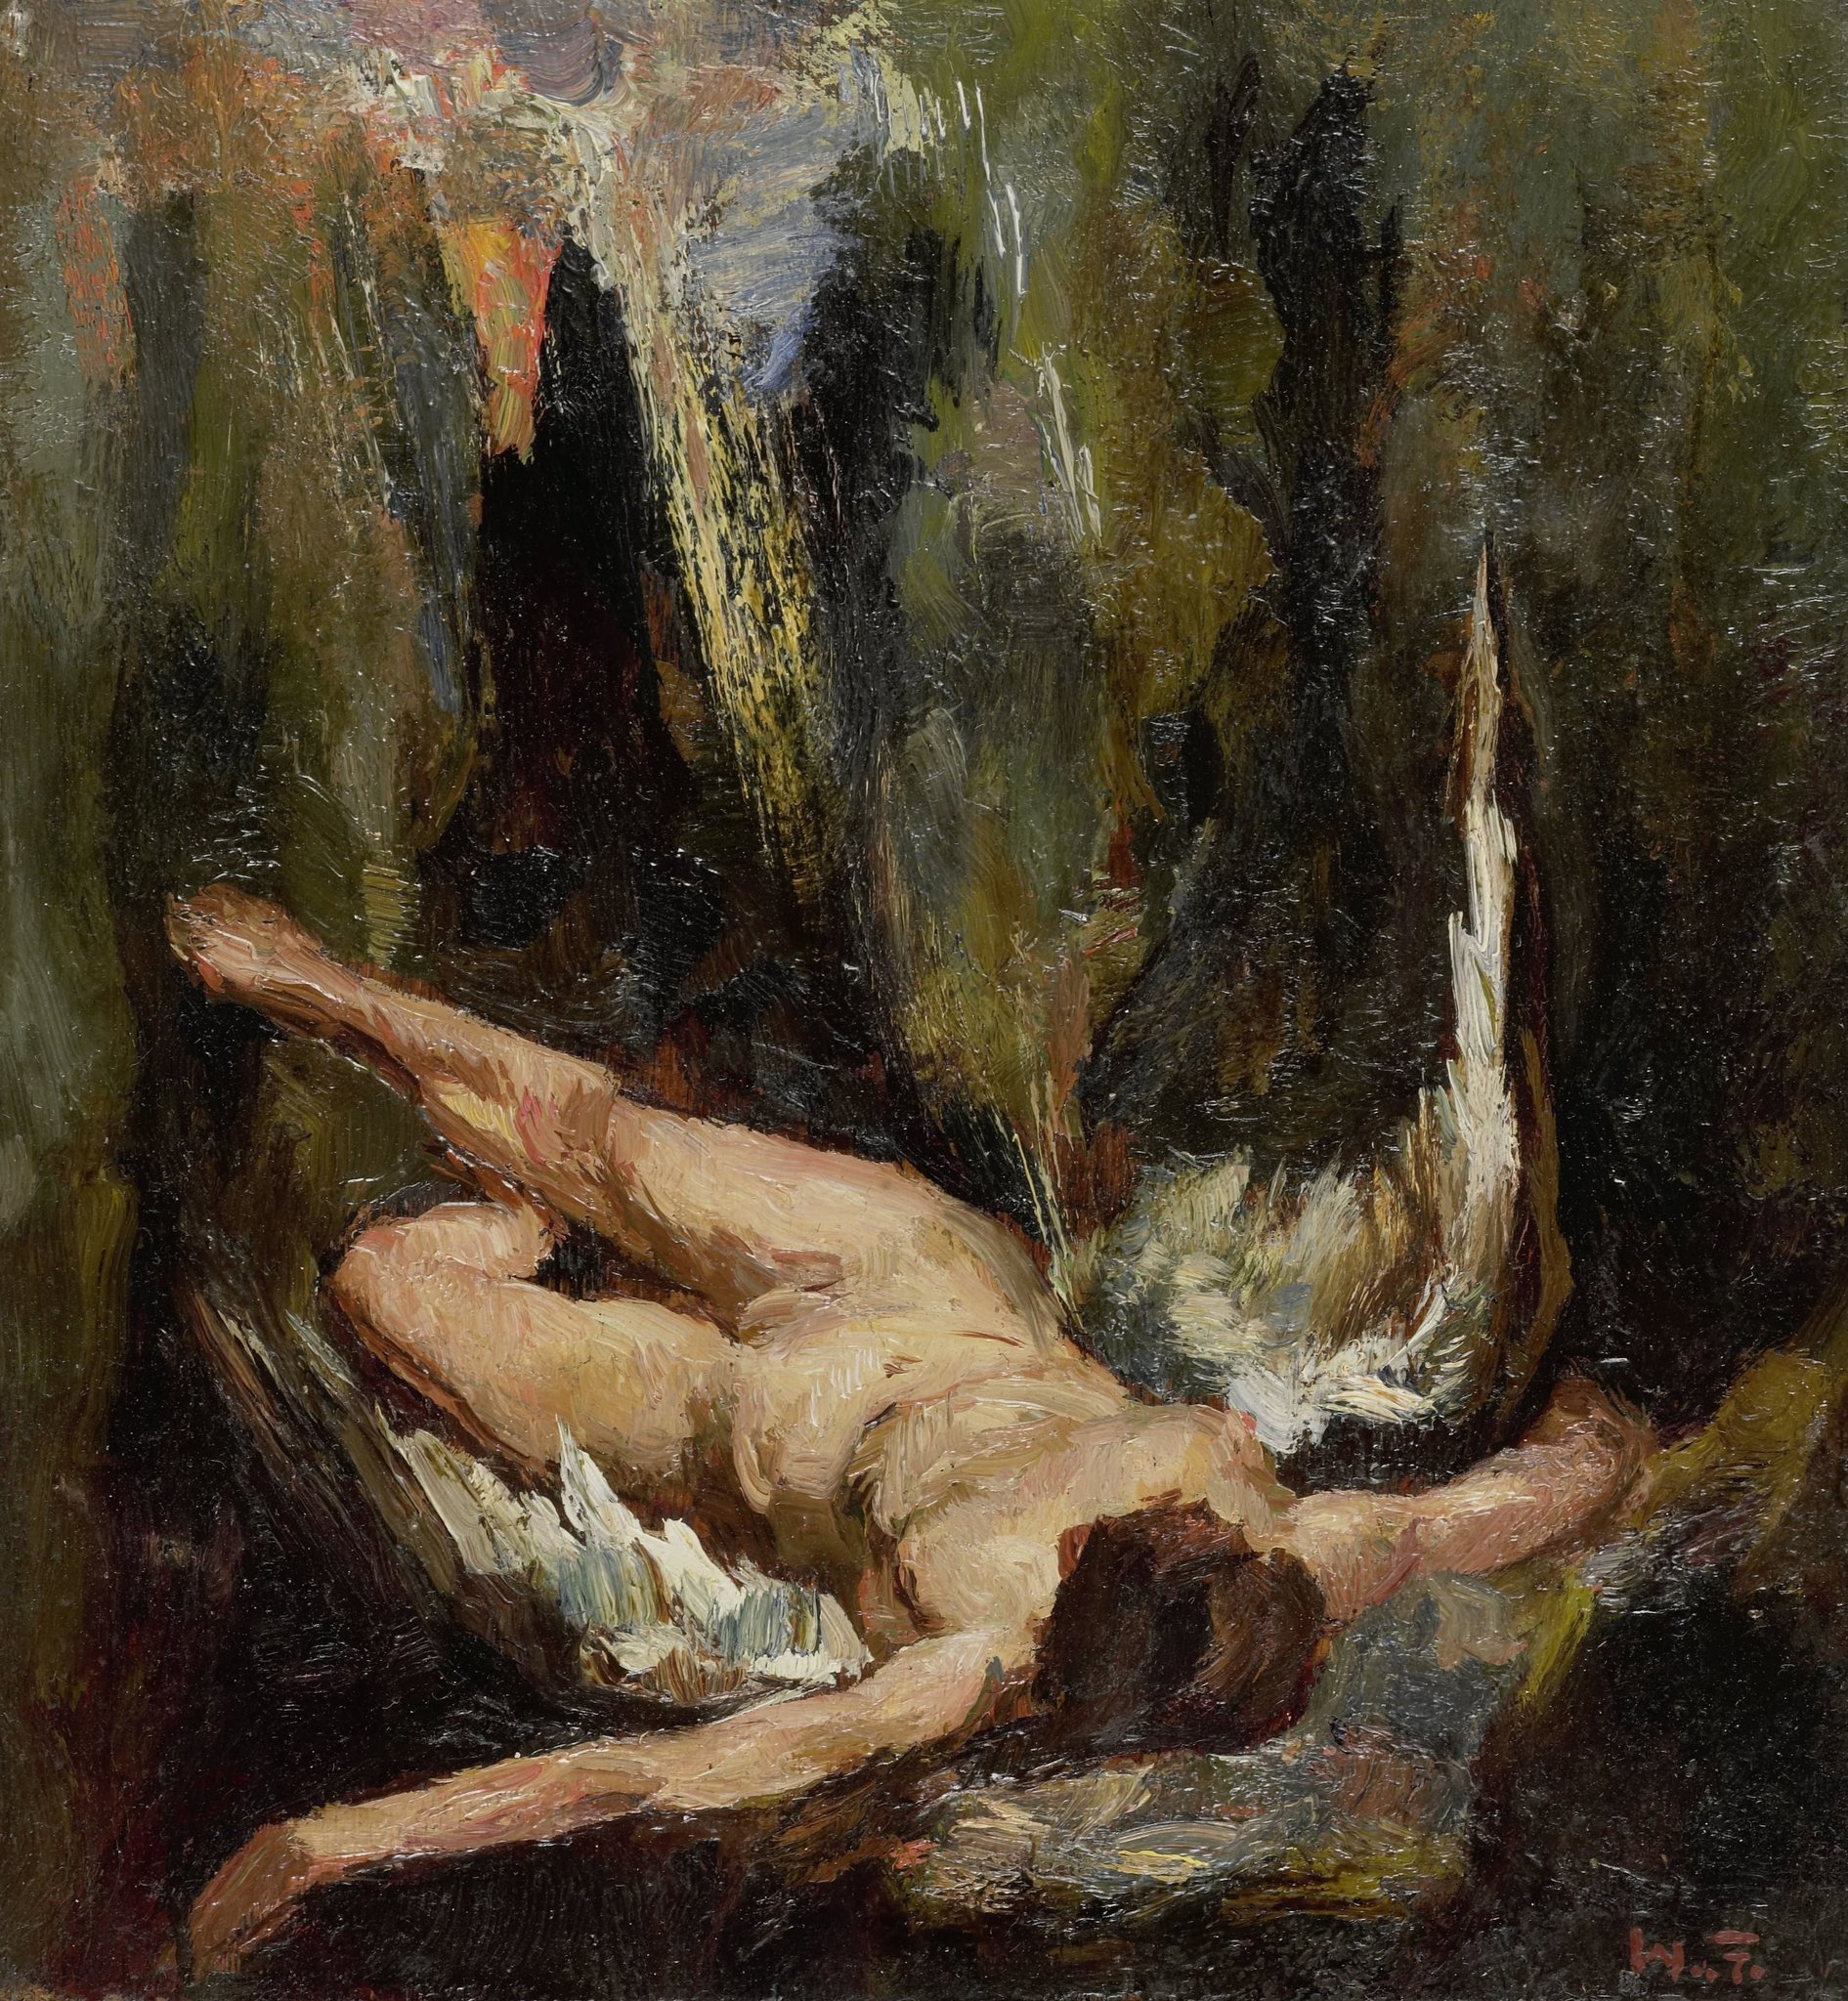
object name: painting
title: De gevallen engel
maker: willem de zwart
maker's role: draughtsman, painter, print maker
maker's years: 1862-1931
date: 1885-1931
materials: oil, paint, panel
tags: fall of the rebel angels, who become devils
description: Een gevallen engel ligt met de armen uitgestrekt op een rotsachtige bodem.